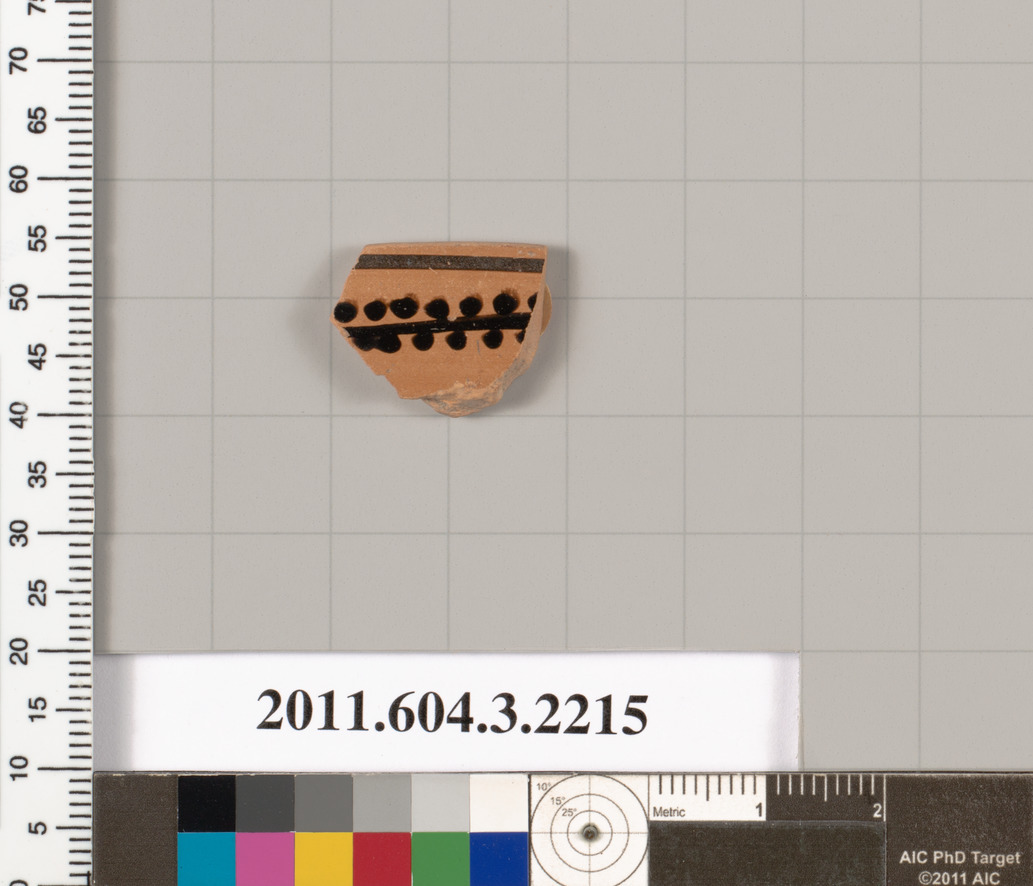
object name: kylix fragment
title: Terracotta rim fragment of a kylix (drinking cup)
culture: greek, attic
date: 600-401 BCE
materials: terracotta